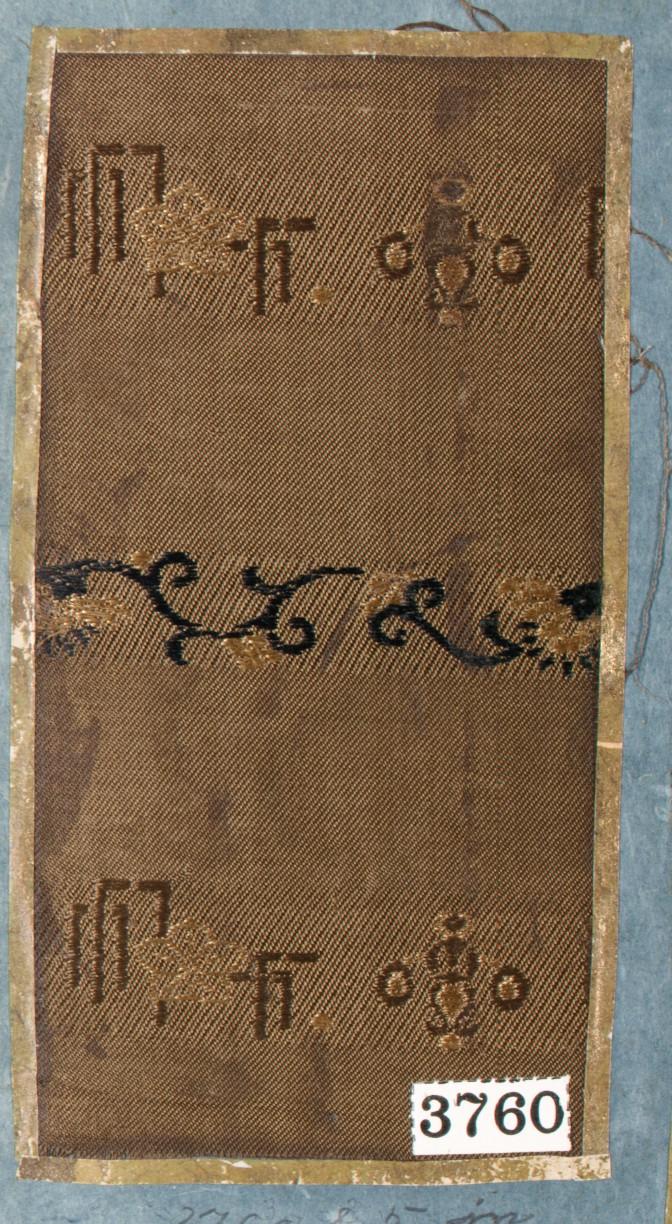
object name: sample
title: Textile Sample from Sample Book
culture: japanese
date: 1801-1900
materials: silk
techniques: tapestry